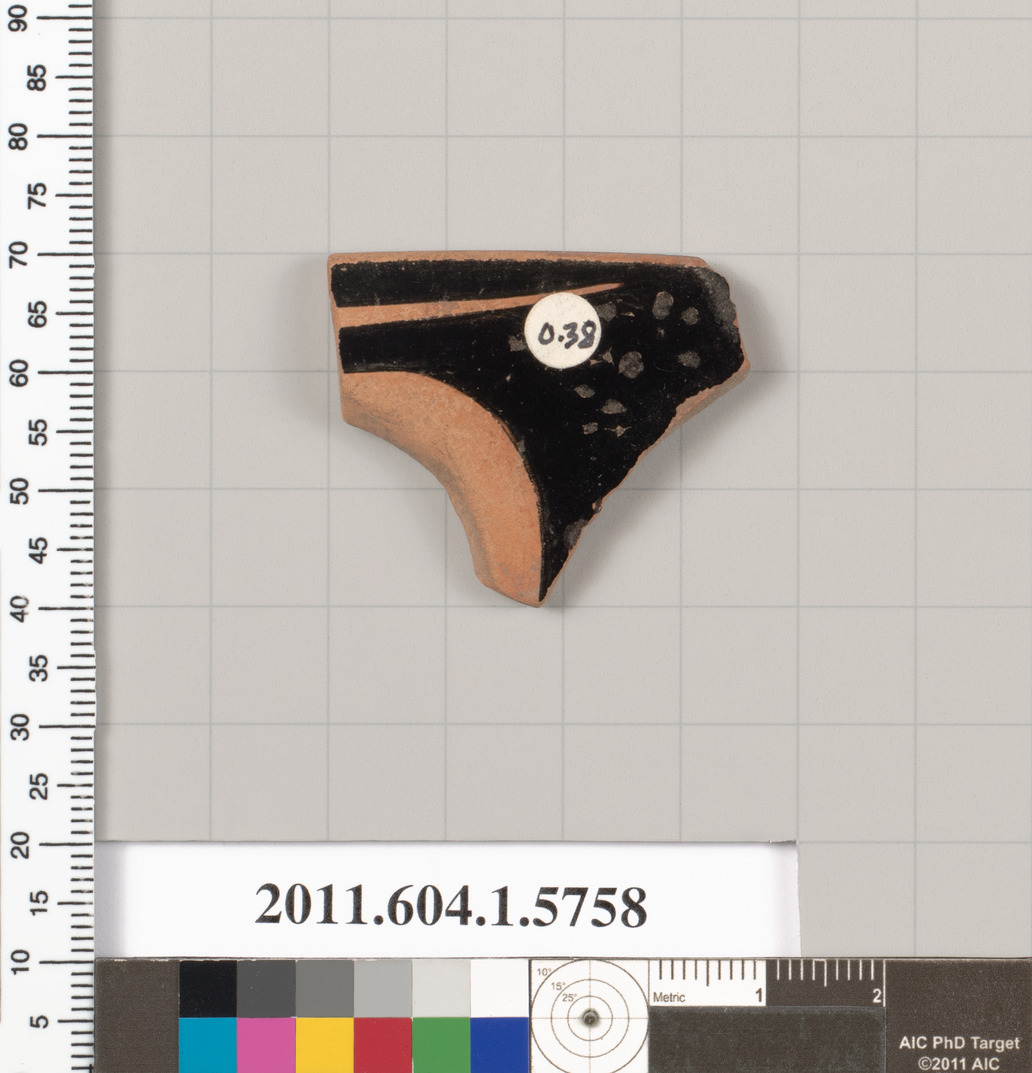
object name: kylix fragment, eye cup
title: Terracotta rim fragment of a kylix: eye-cup (drinking cup)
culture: greek, attic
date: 520-510 BCE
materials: terracotta